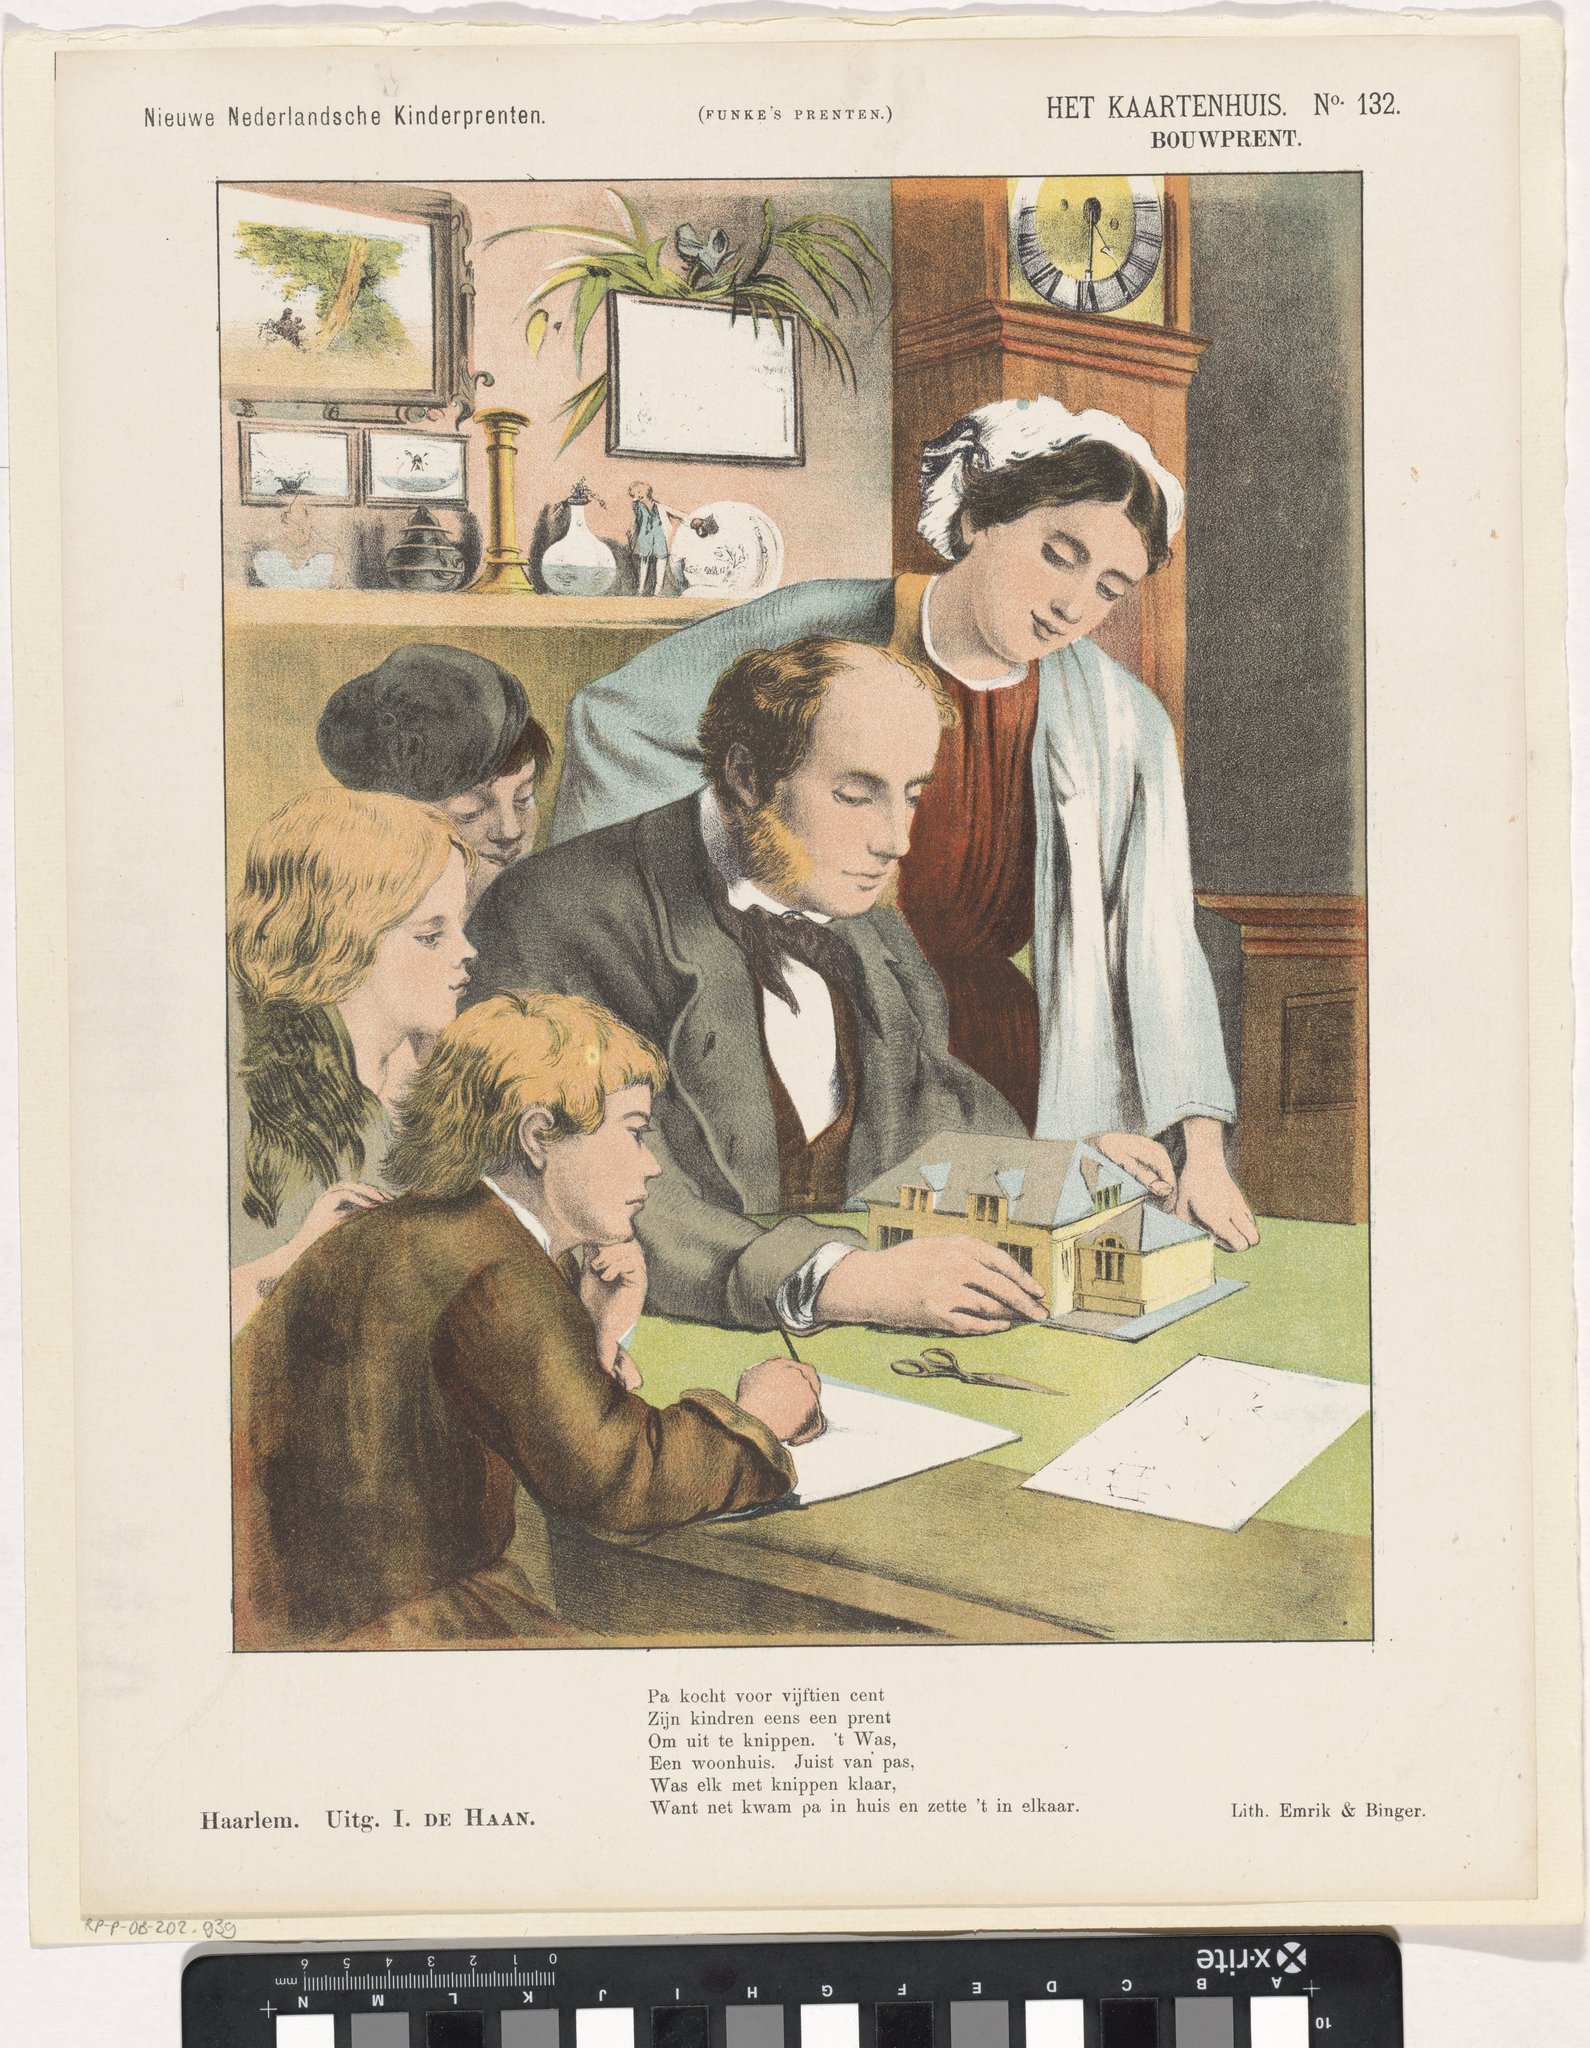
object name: popular print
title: Funke's prenten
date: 1875-1903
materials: paper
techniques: lithograph, letterpress printing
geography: haarlem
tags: family life at home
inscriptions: collector's mark: Lugt 2760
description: Blad met grote voorstelling van een gezin aan een tafel. De vader van het gezin bouwt een huis van een bouwprent. De moeder en de kinderen kijken toe. Onder de afbeelding een vers. Genummerd rechtsboven: No. 132.